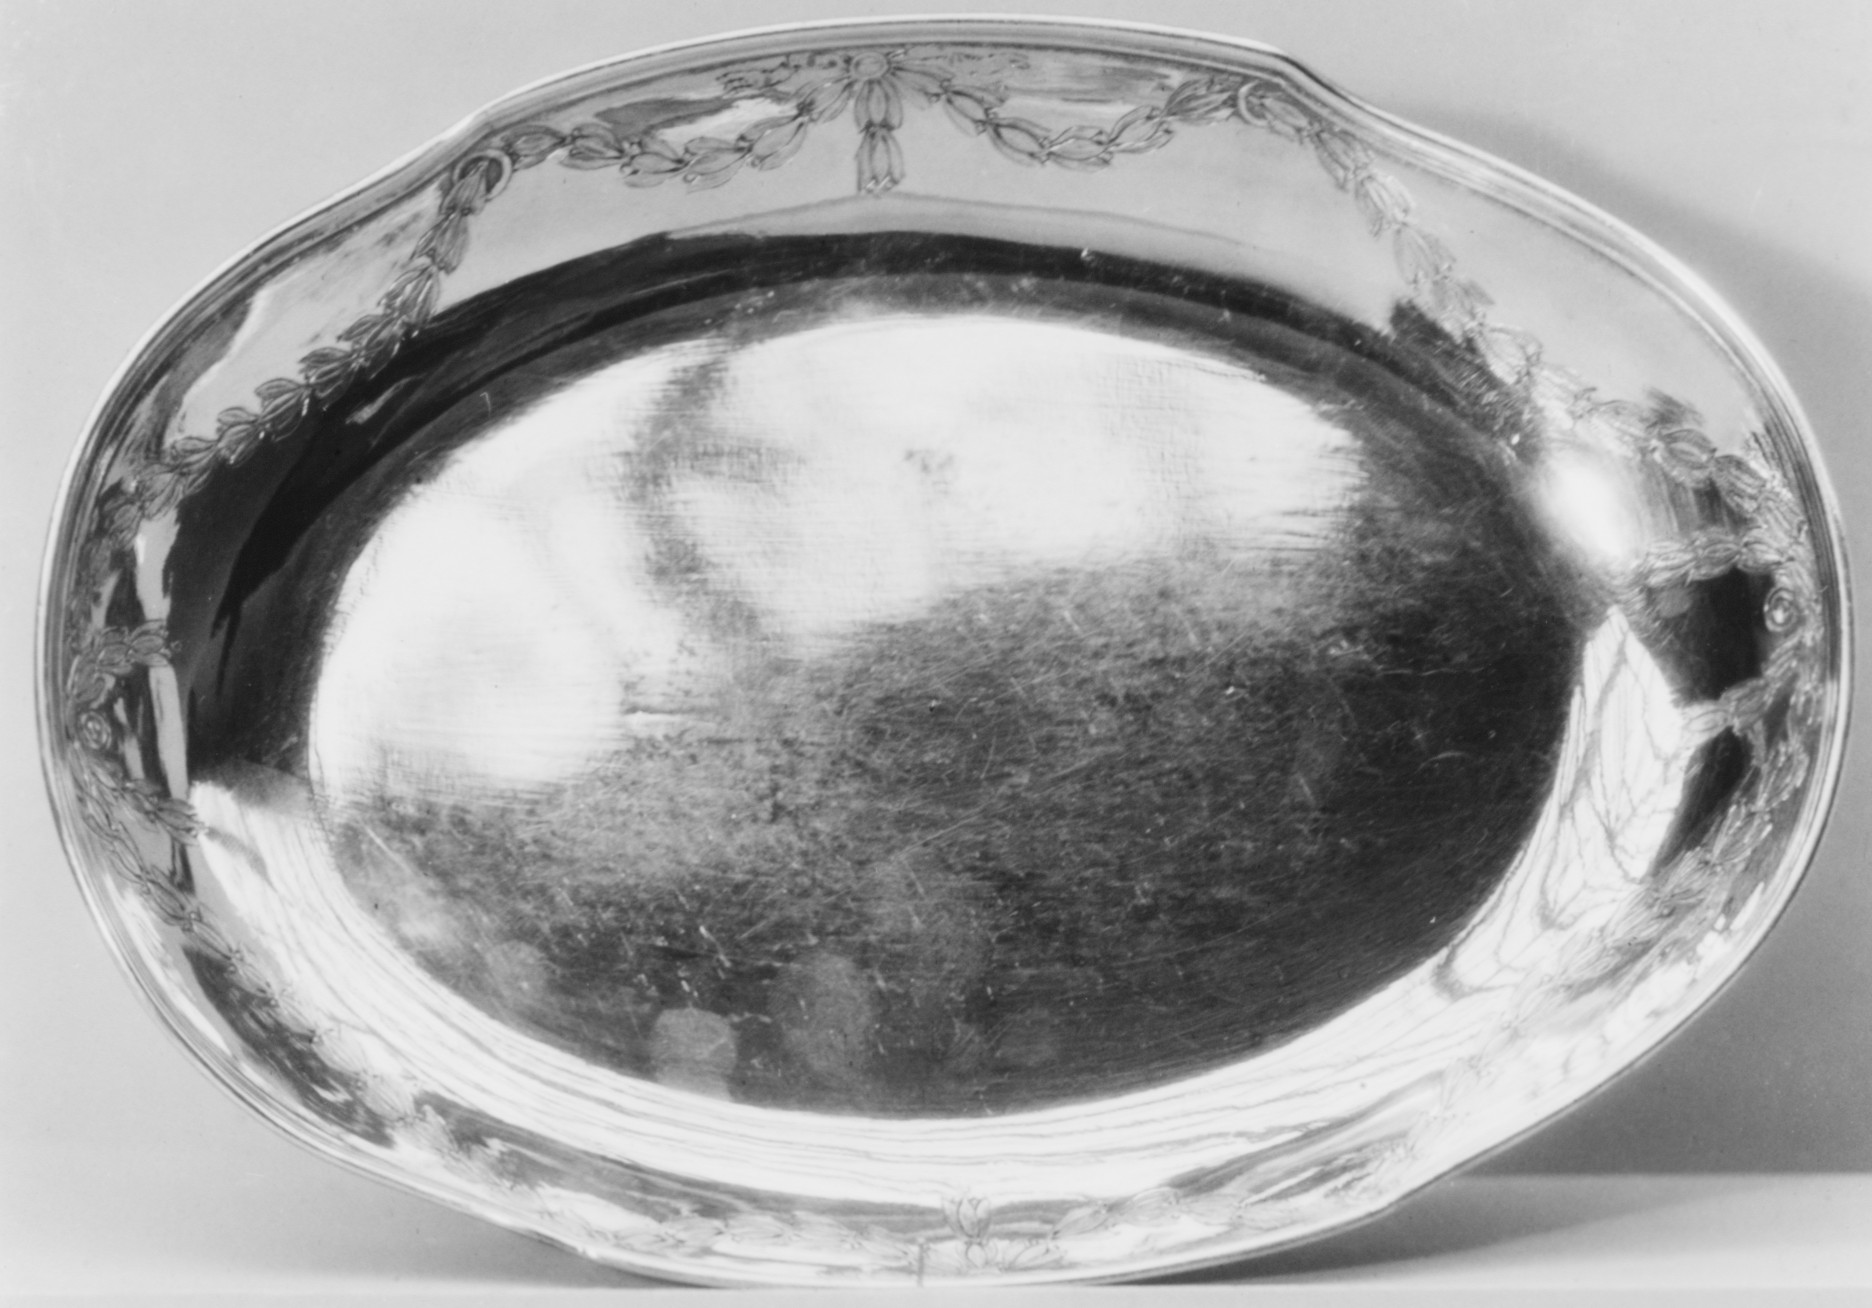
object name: stand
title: Stand for a bowl with cover (plateau)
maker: jacques-pierre marteau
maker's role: maker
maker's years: 1679-1779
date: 1769-1770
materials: silver gilt